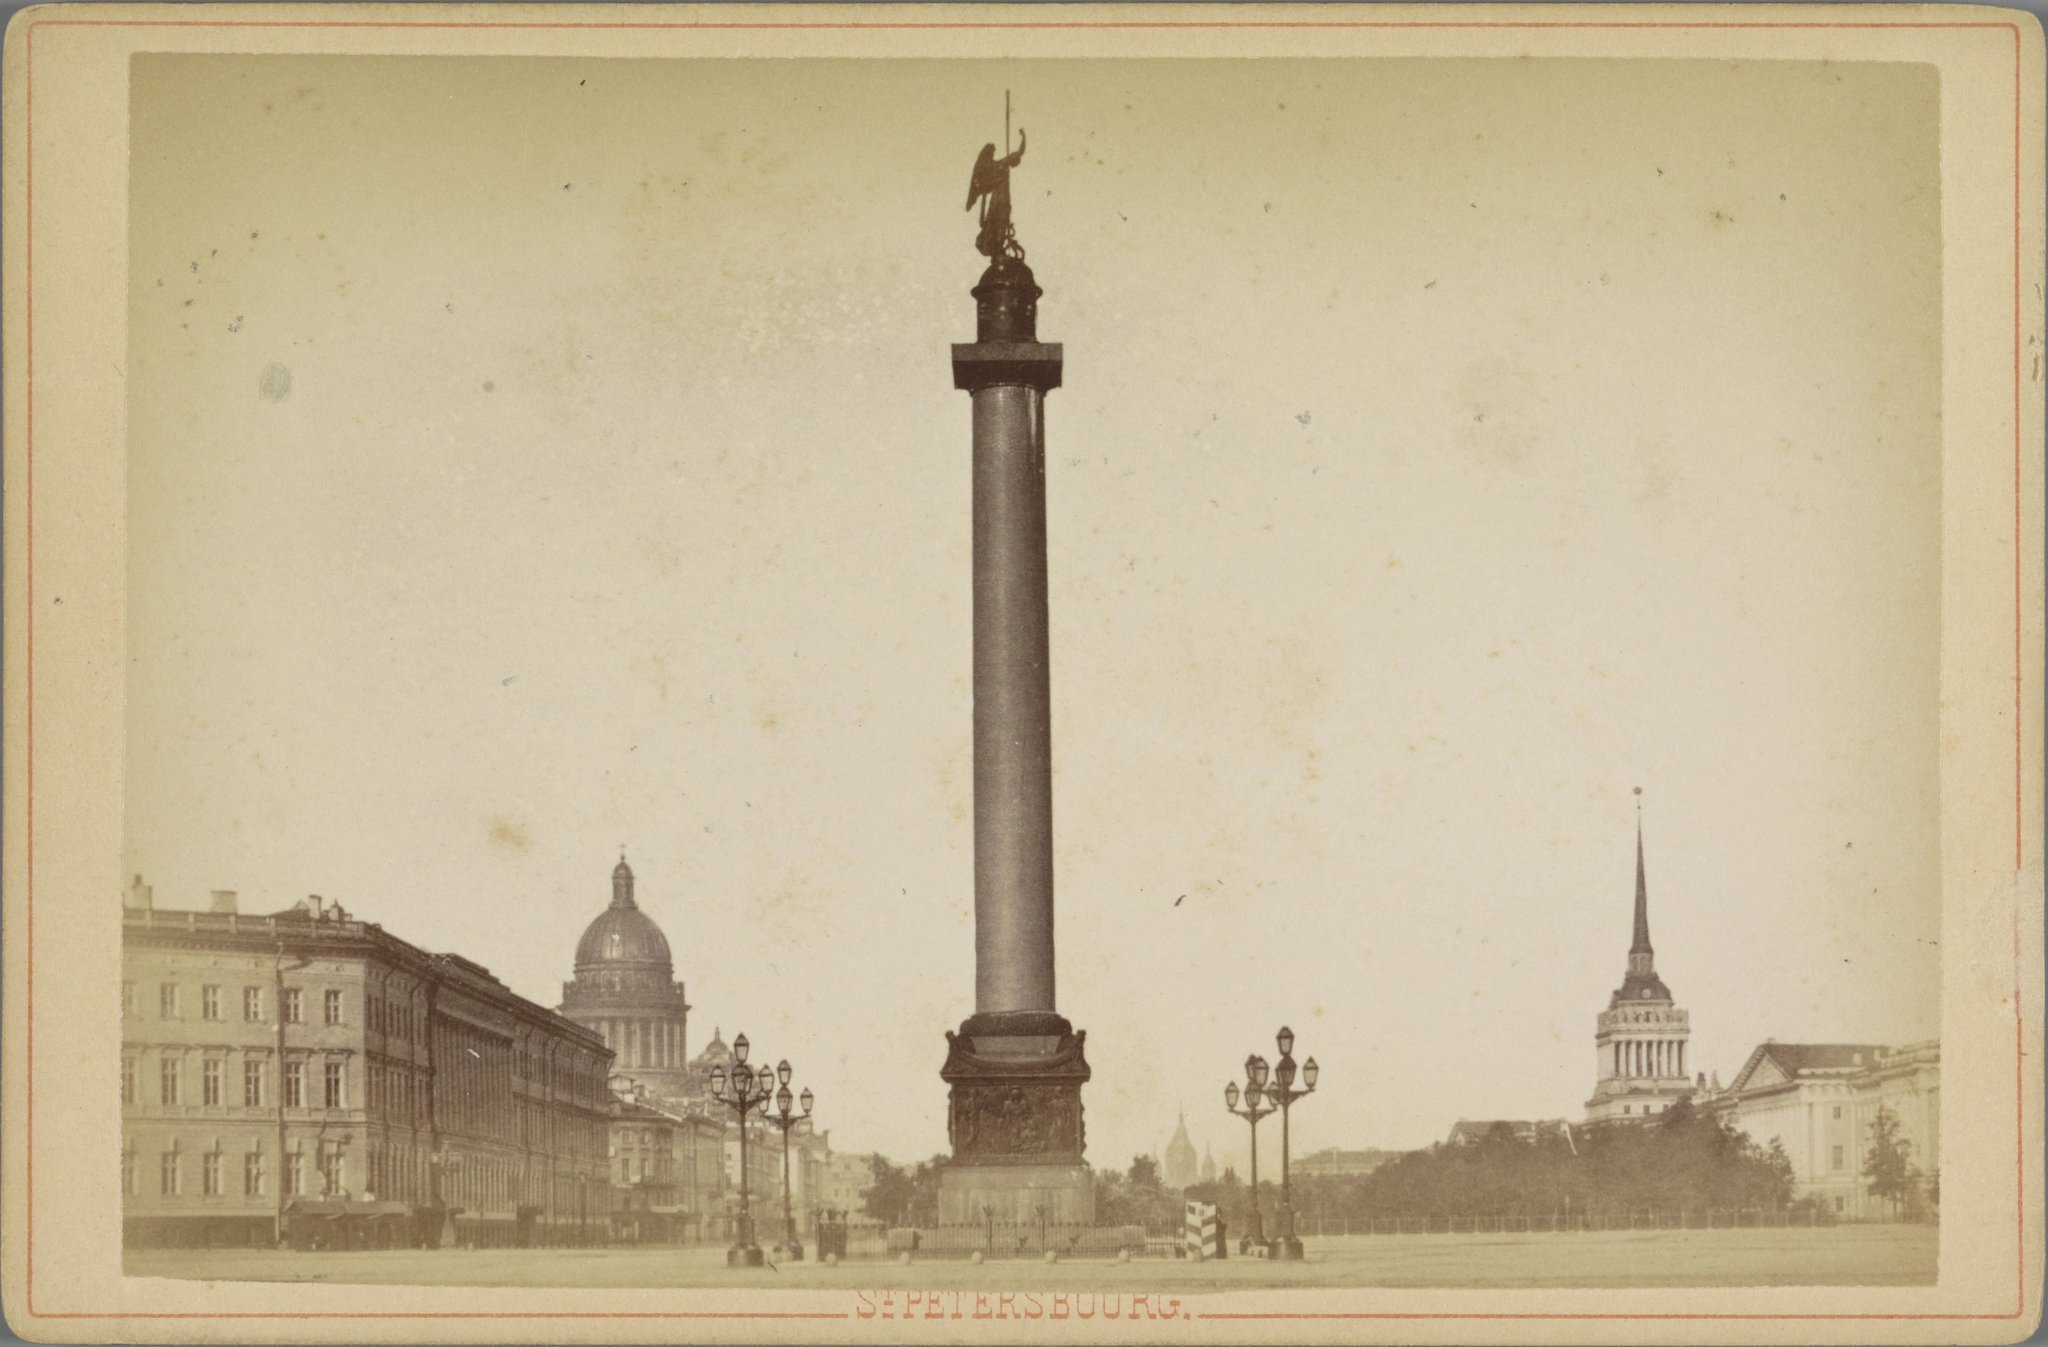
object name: cabinet photograph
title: Alexanderzuil en het Plein van de Admiraliteit in Sint Petersburg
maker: joseph daziaro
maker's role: publisher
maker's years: 1831-1892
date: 1880-1900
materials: cardboard, photographic support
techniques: albumen print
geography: sint-petersburg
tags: triumphal column with helical friezes (+ variant), square, place, circus, etc. (+ city(-scape) with figures, staffage)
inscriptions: inscription: ‘Colonne Alexandre I’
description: Onderdeel van Fotoalbum met opnames van Sint-Petersburg.